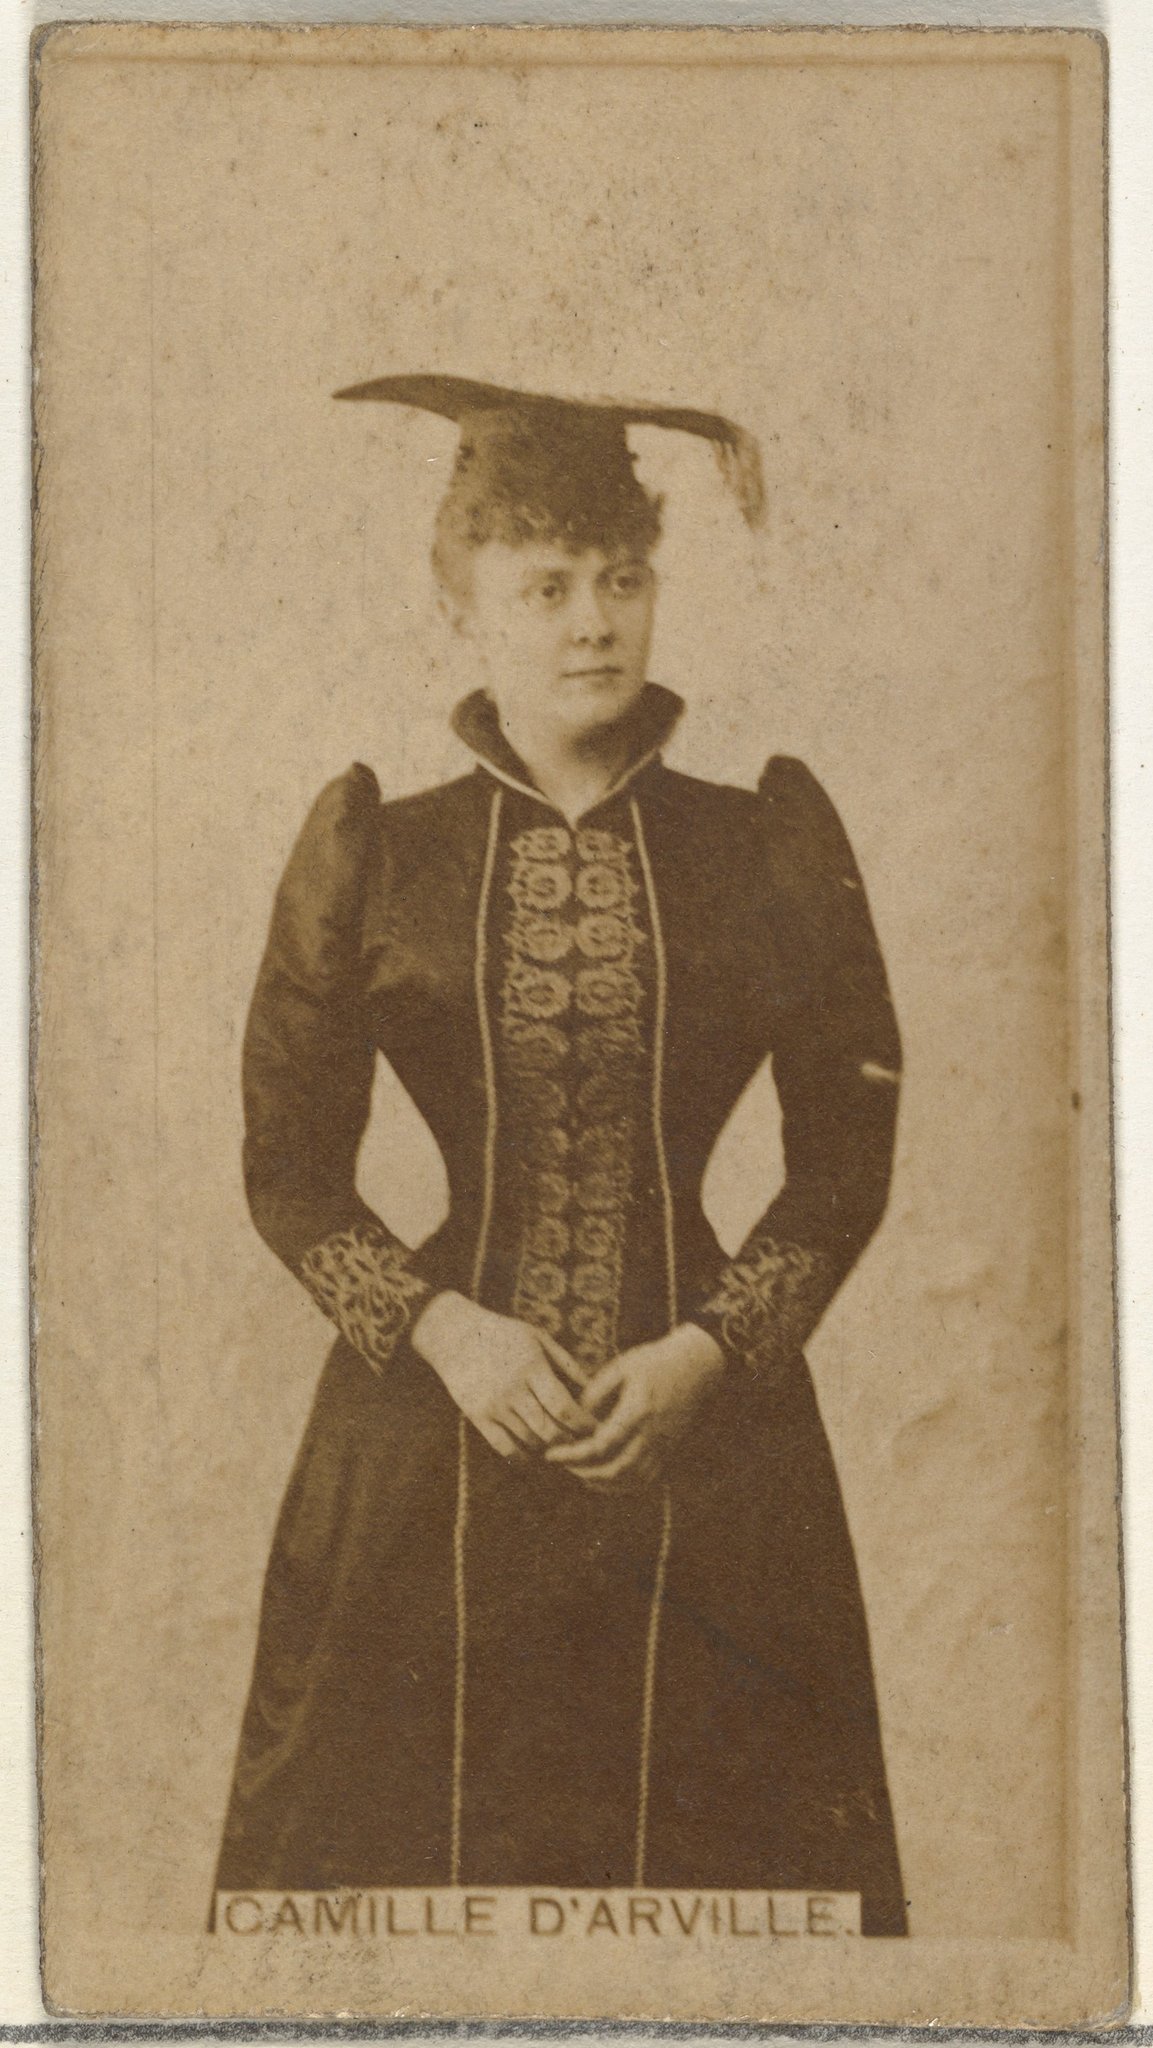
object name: photograph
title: Camille D'arville, from the Actors and Actresses series (N145-8) issued by Duke Sons & Co. to promote Duke Cigarettes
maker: w. duke, sons & co.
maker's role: publisher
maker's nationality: american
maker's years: 1870-1920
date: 1891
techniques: albumen silver print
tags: portraits,women,actresses